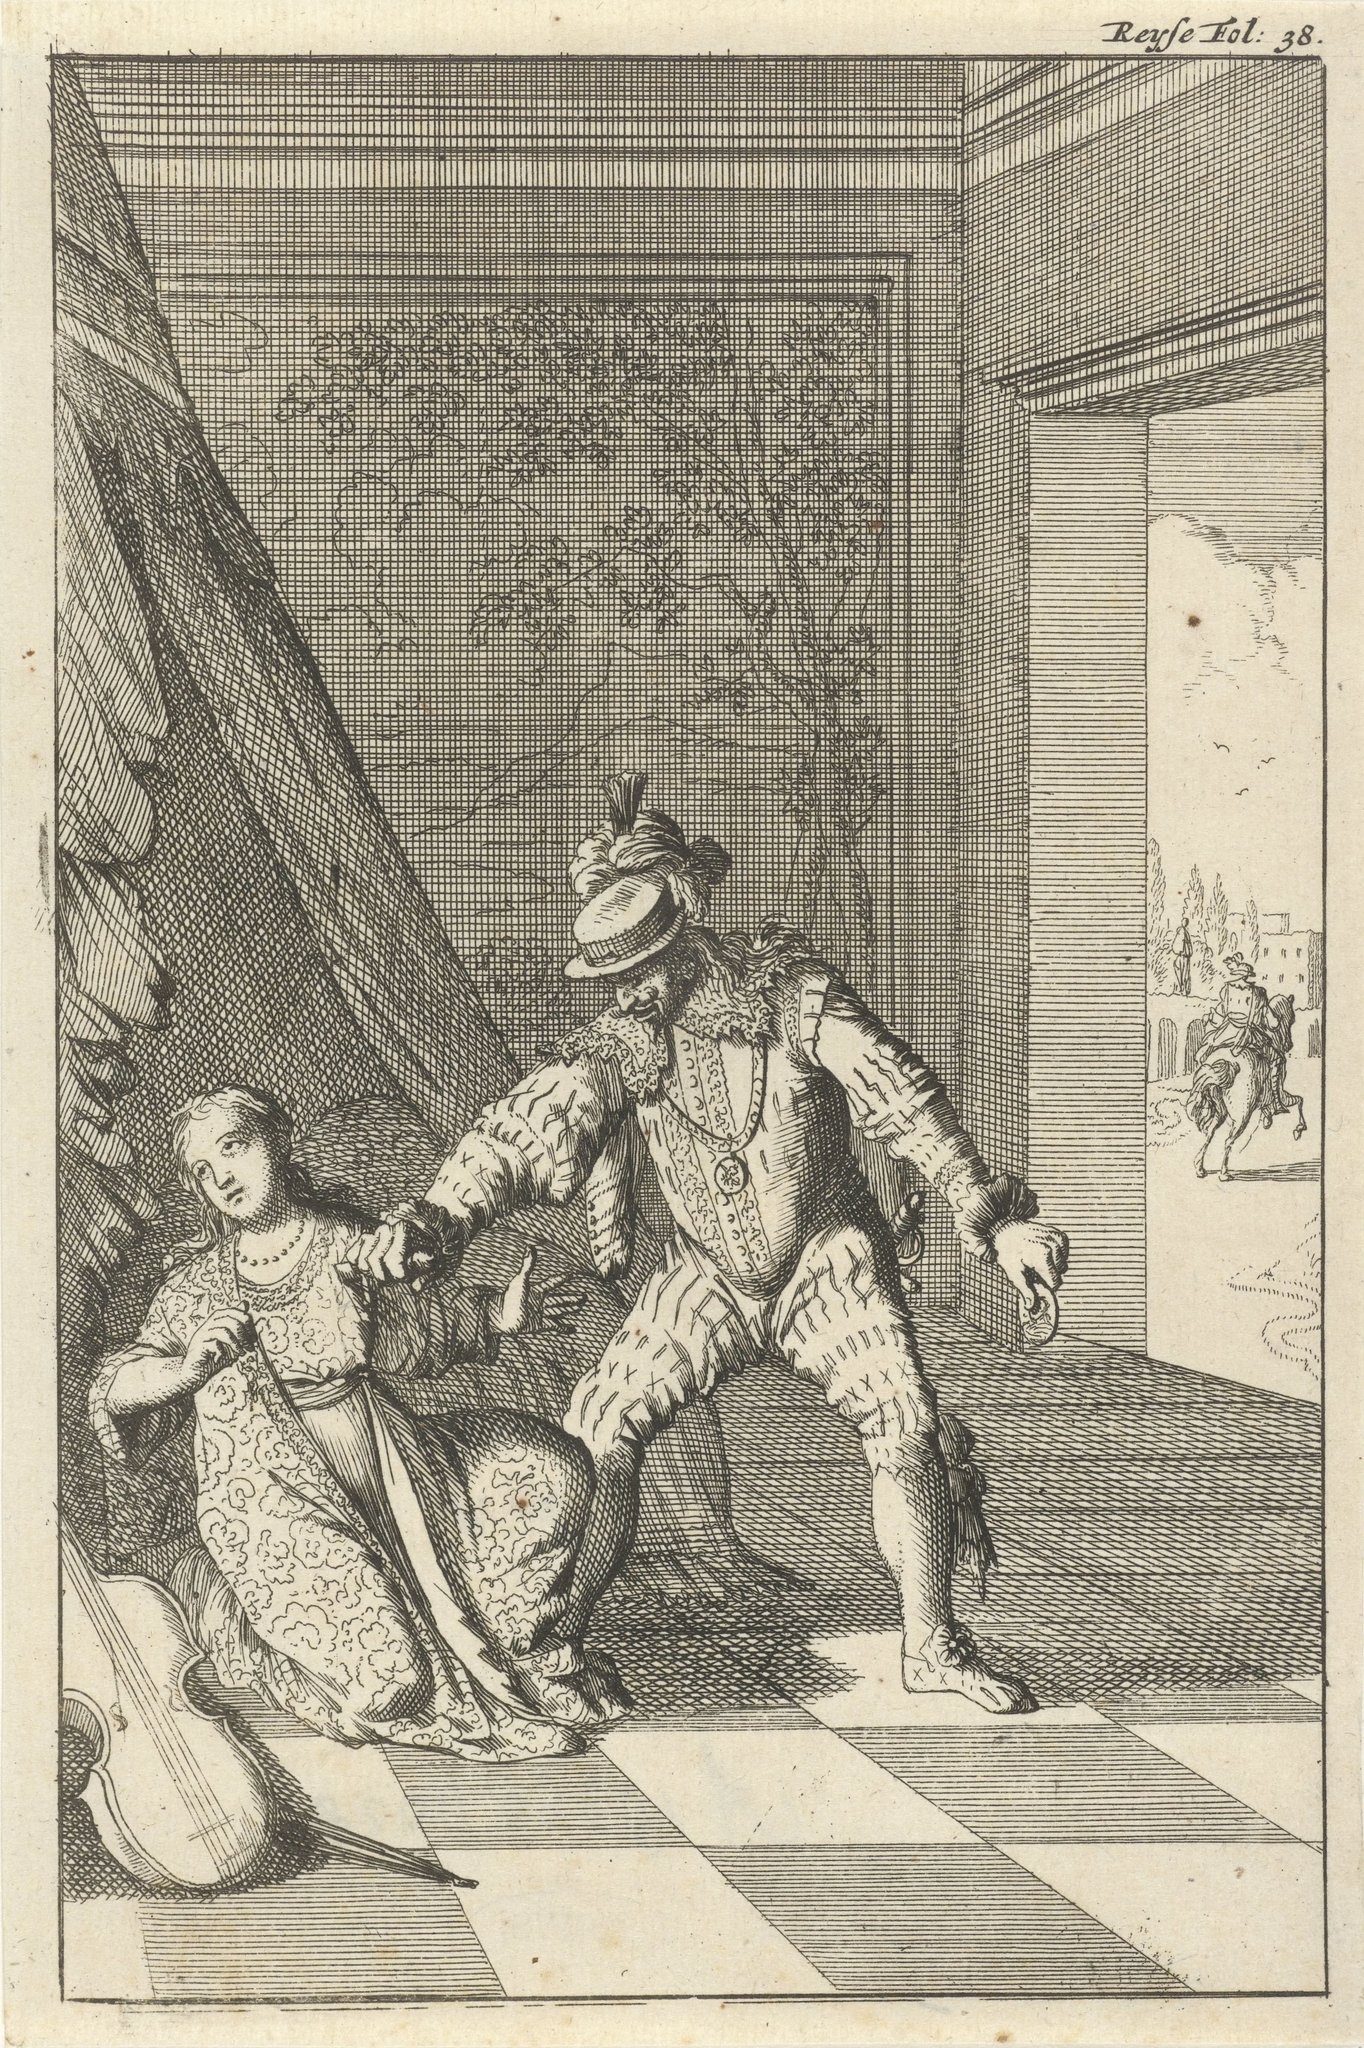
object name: print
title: Markiezin van Barbaran door haar echtgenoot doodgestoken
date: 1696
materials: paper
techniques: etching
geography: amsterdam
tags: violent death by dagger, knife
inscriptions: collector's mark: Lugt 2228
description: Illustratie uit: D'Aulnoy, Marie Cathérine Le Jumel de Barneville. Reyse door Spaignien, neffens memorien van des selfs hofs. Utrecht: Willem Broedelet, 1696.